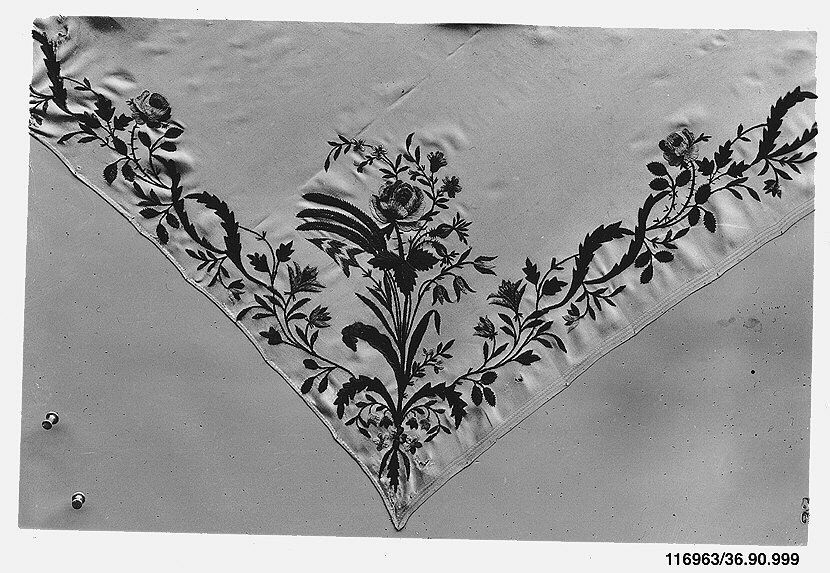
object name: piece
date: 1701-1800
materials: silk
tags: flowers,leaves